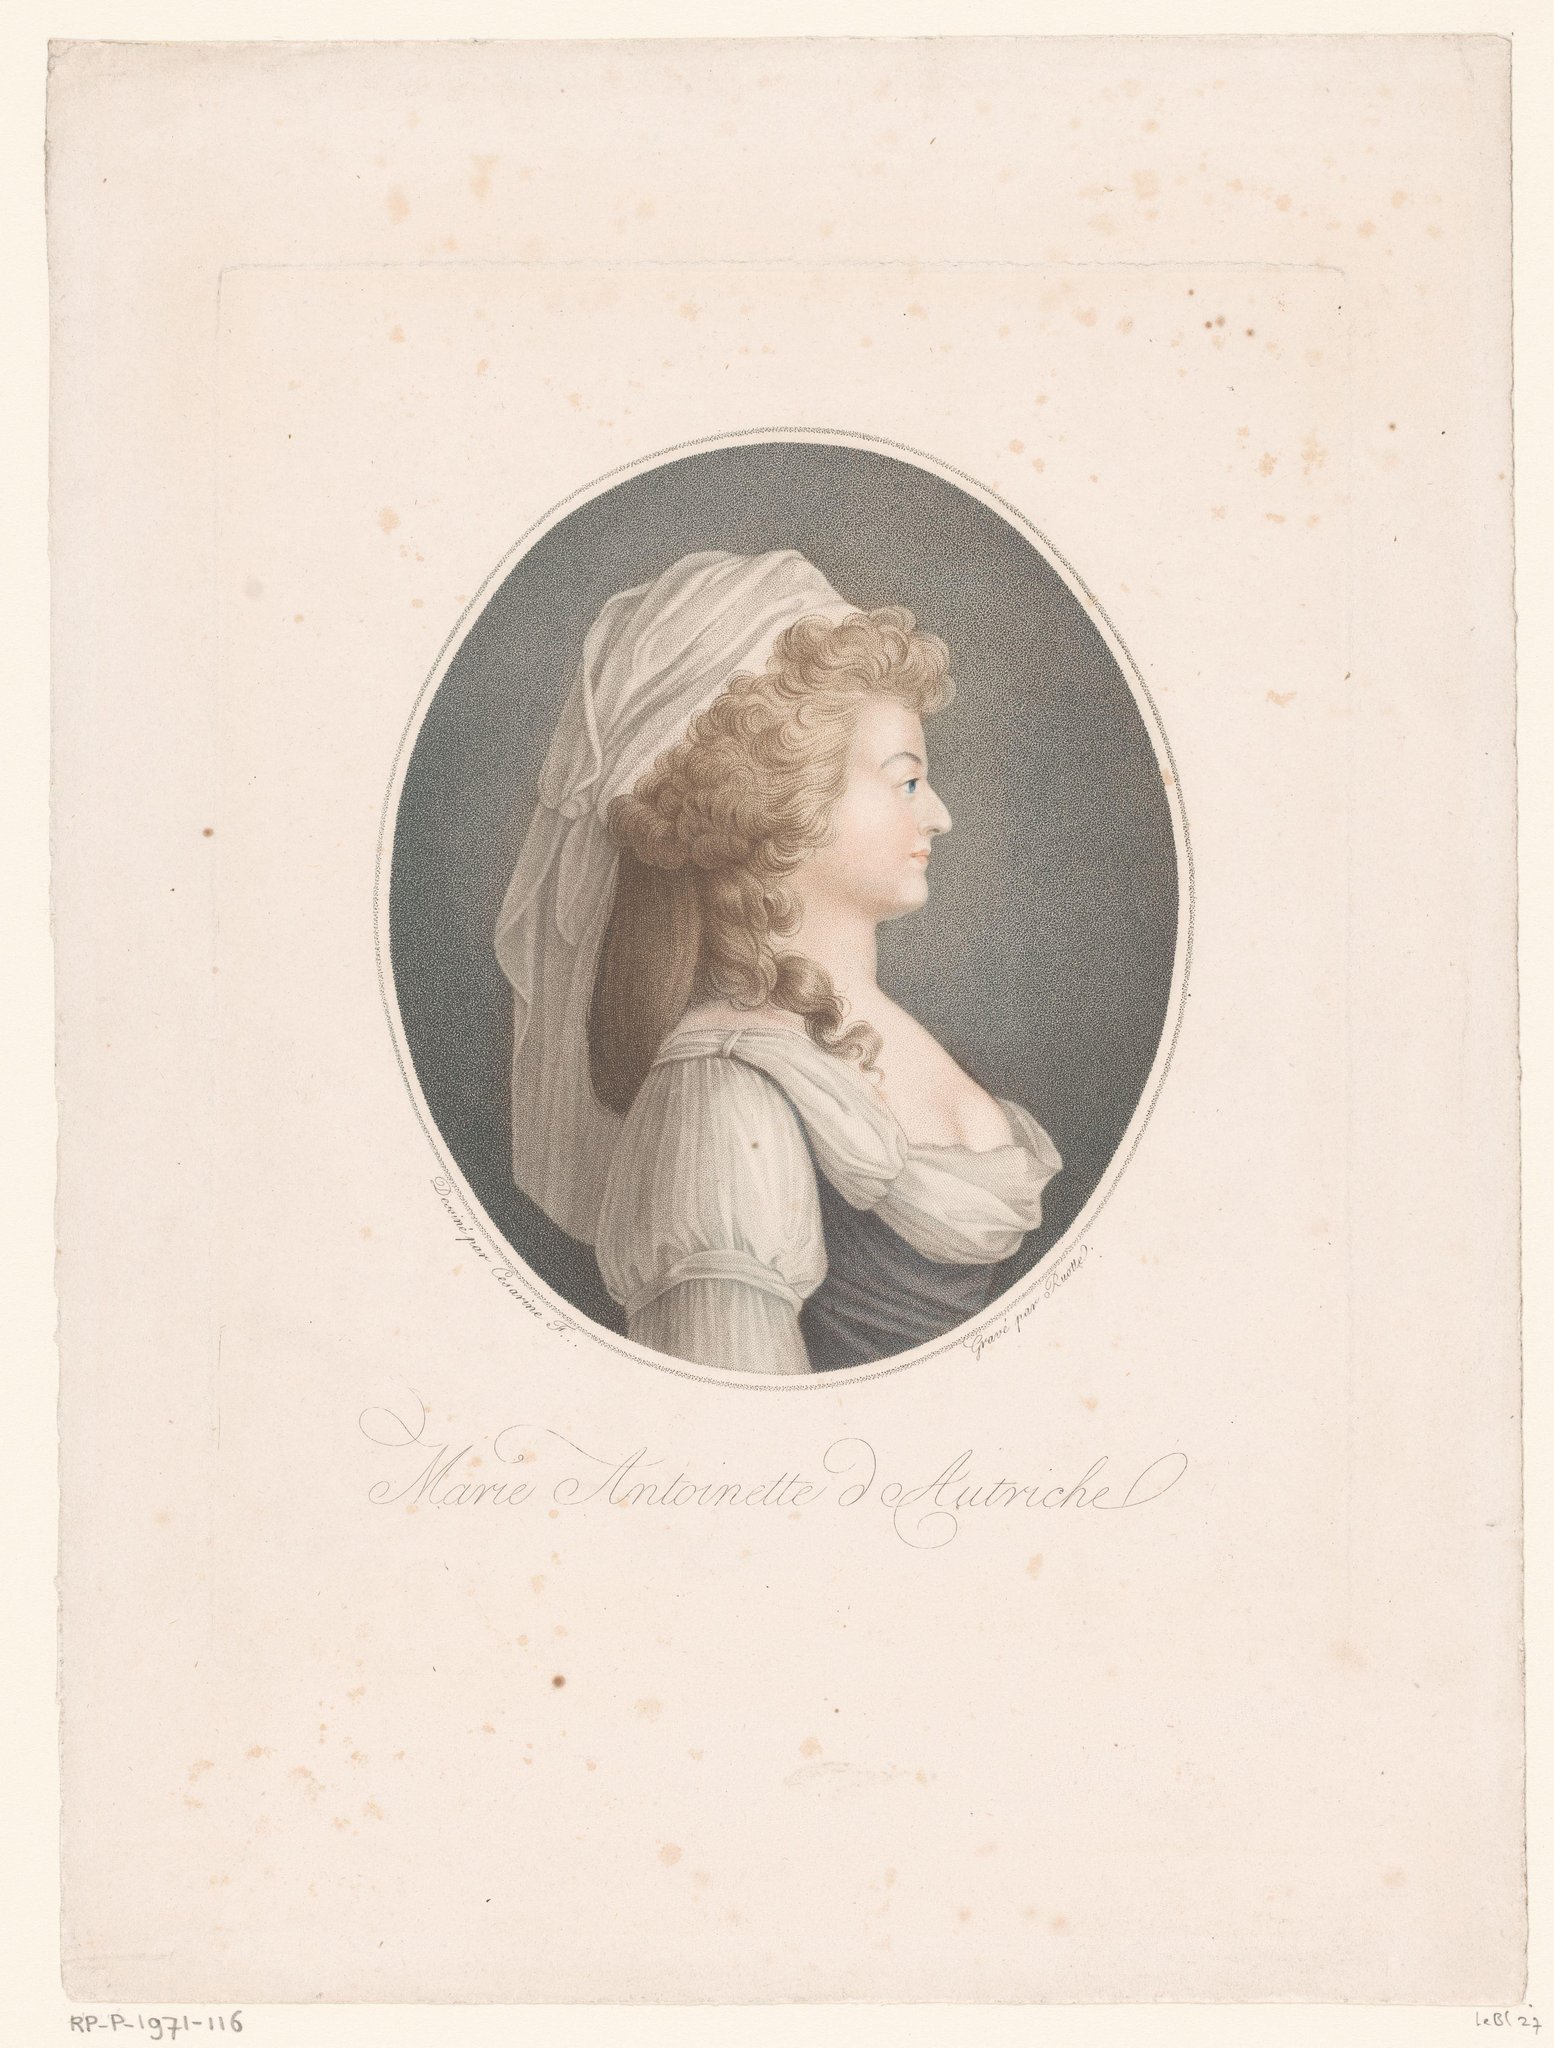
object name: print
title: Portret van Marie Antoinette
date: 1791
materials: paper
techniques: etching, lithography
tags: vienna, paris, marie antoinette, adult woman, historical persons, queen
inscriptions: collector's mark: Lugt 2228, collector's mark: Lugt 2760